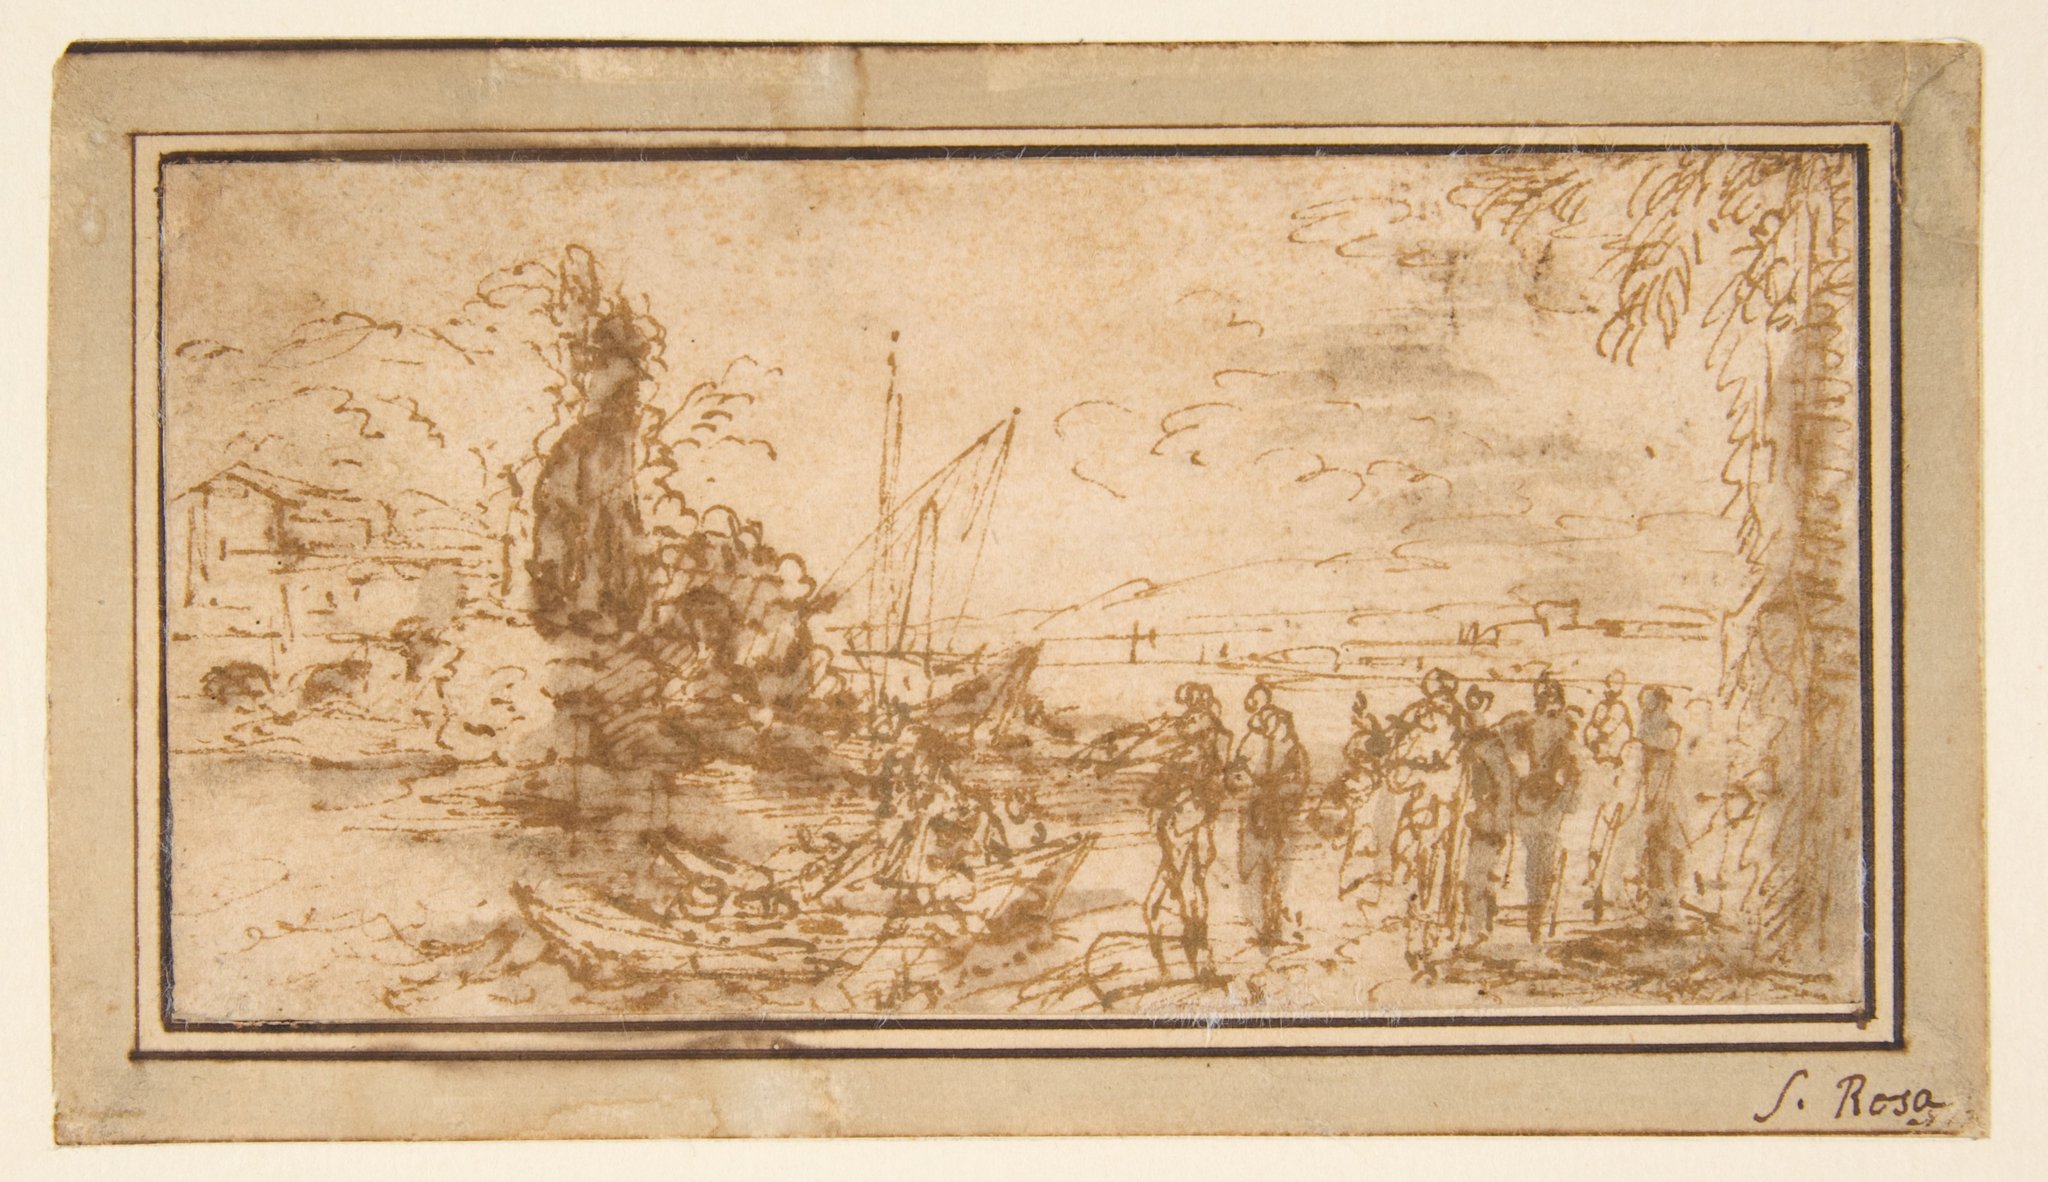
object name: drawing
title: Marine landscape with figures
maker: salvator rosa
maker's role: artist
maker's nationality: italian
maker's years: 1615-1673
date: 1615-1673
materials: ink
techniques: pen, wash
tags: landscapes,boats